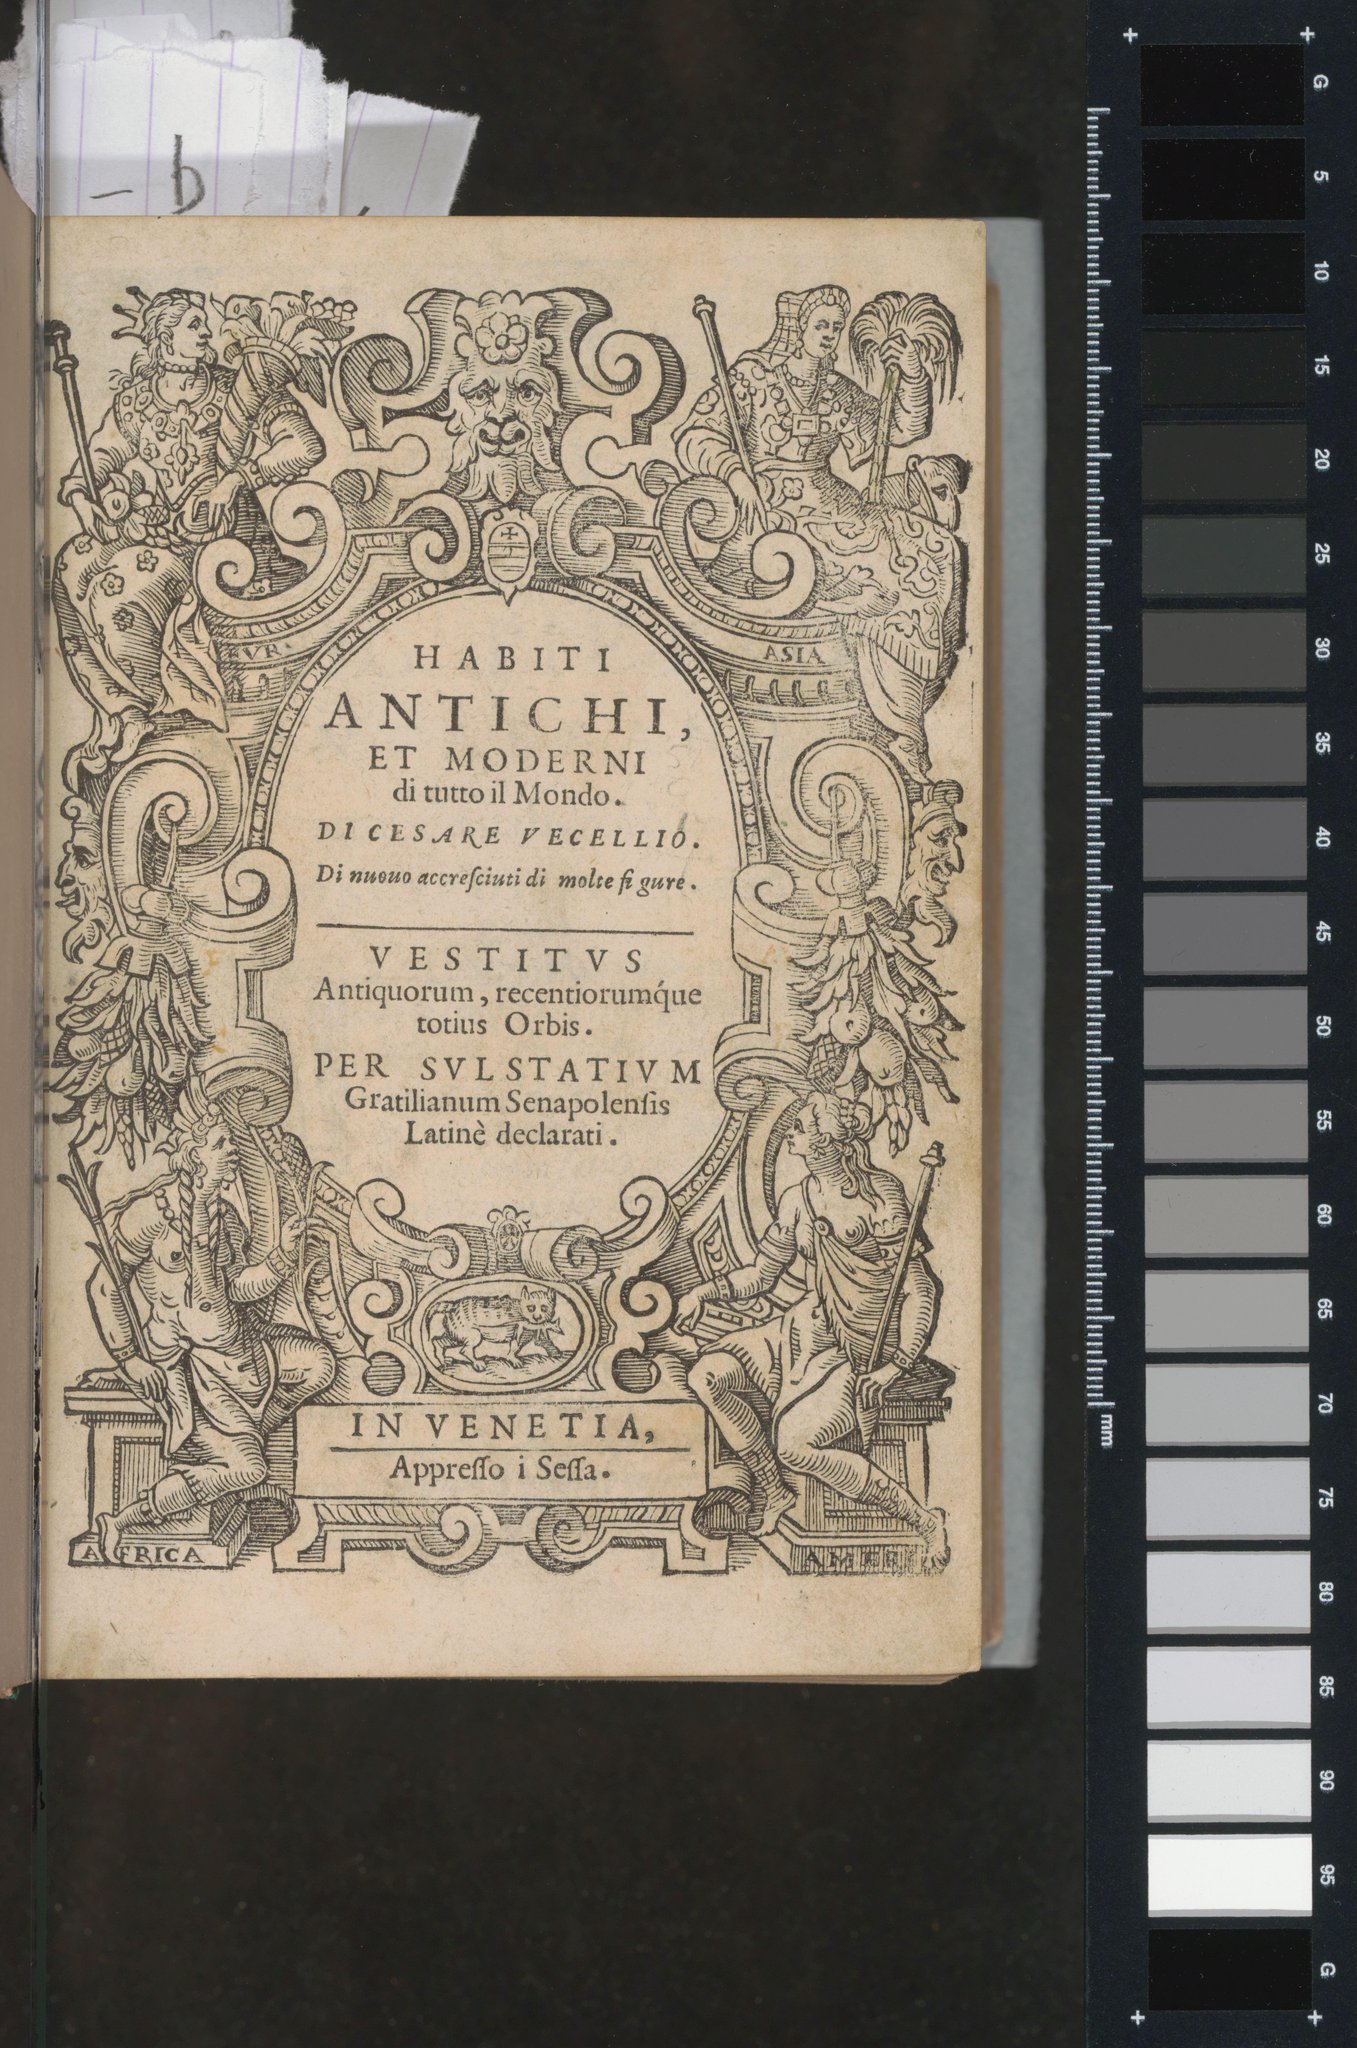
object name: album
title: Habiti antichi, et moderni di tutto il mondo : di nuovo accresciuti di molte figure : vestitus antiquorum, recentiorumque totius orbis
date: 1598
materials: paper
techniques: letterpress printing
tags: fashion plates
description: Titelblad. De titel ' Habiti antichi, et moderni di tutto il mondo : di nuovo accresciuti di molte figure : vestitus antiquorum, recentiorumque totius orbis' is gevat in een ornamentrand met in de vier hoeken personificaties van de vier werelddelen Europa, Azië, Afrika, Amerika.